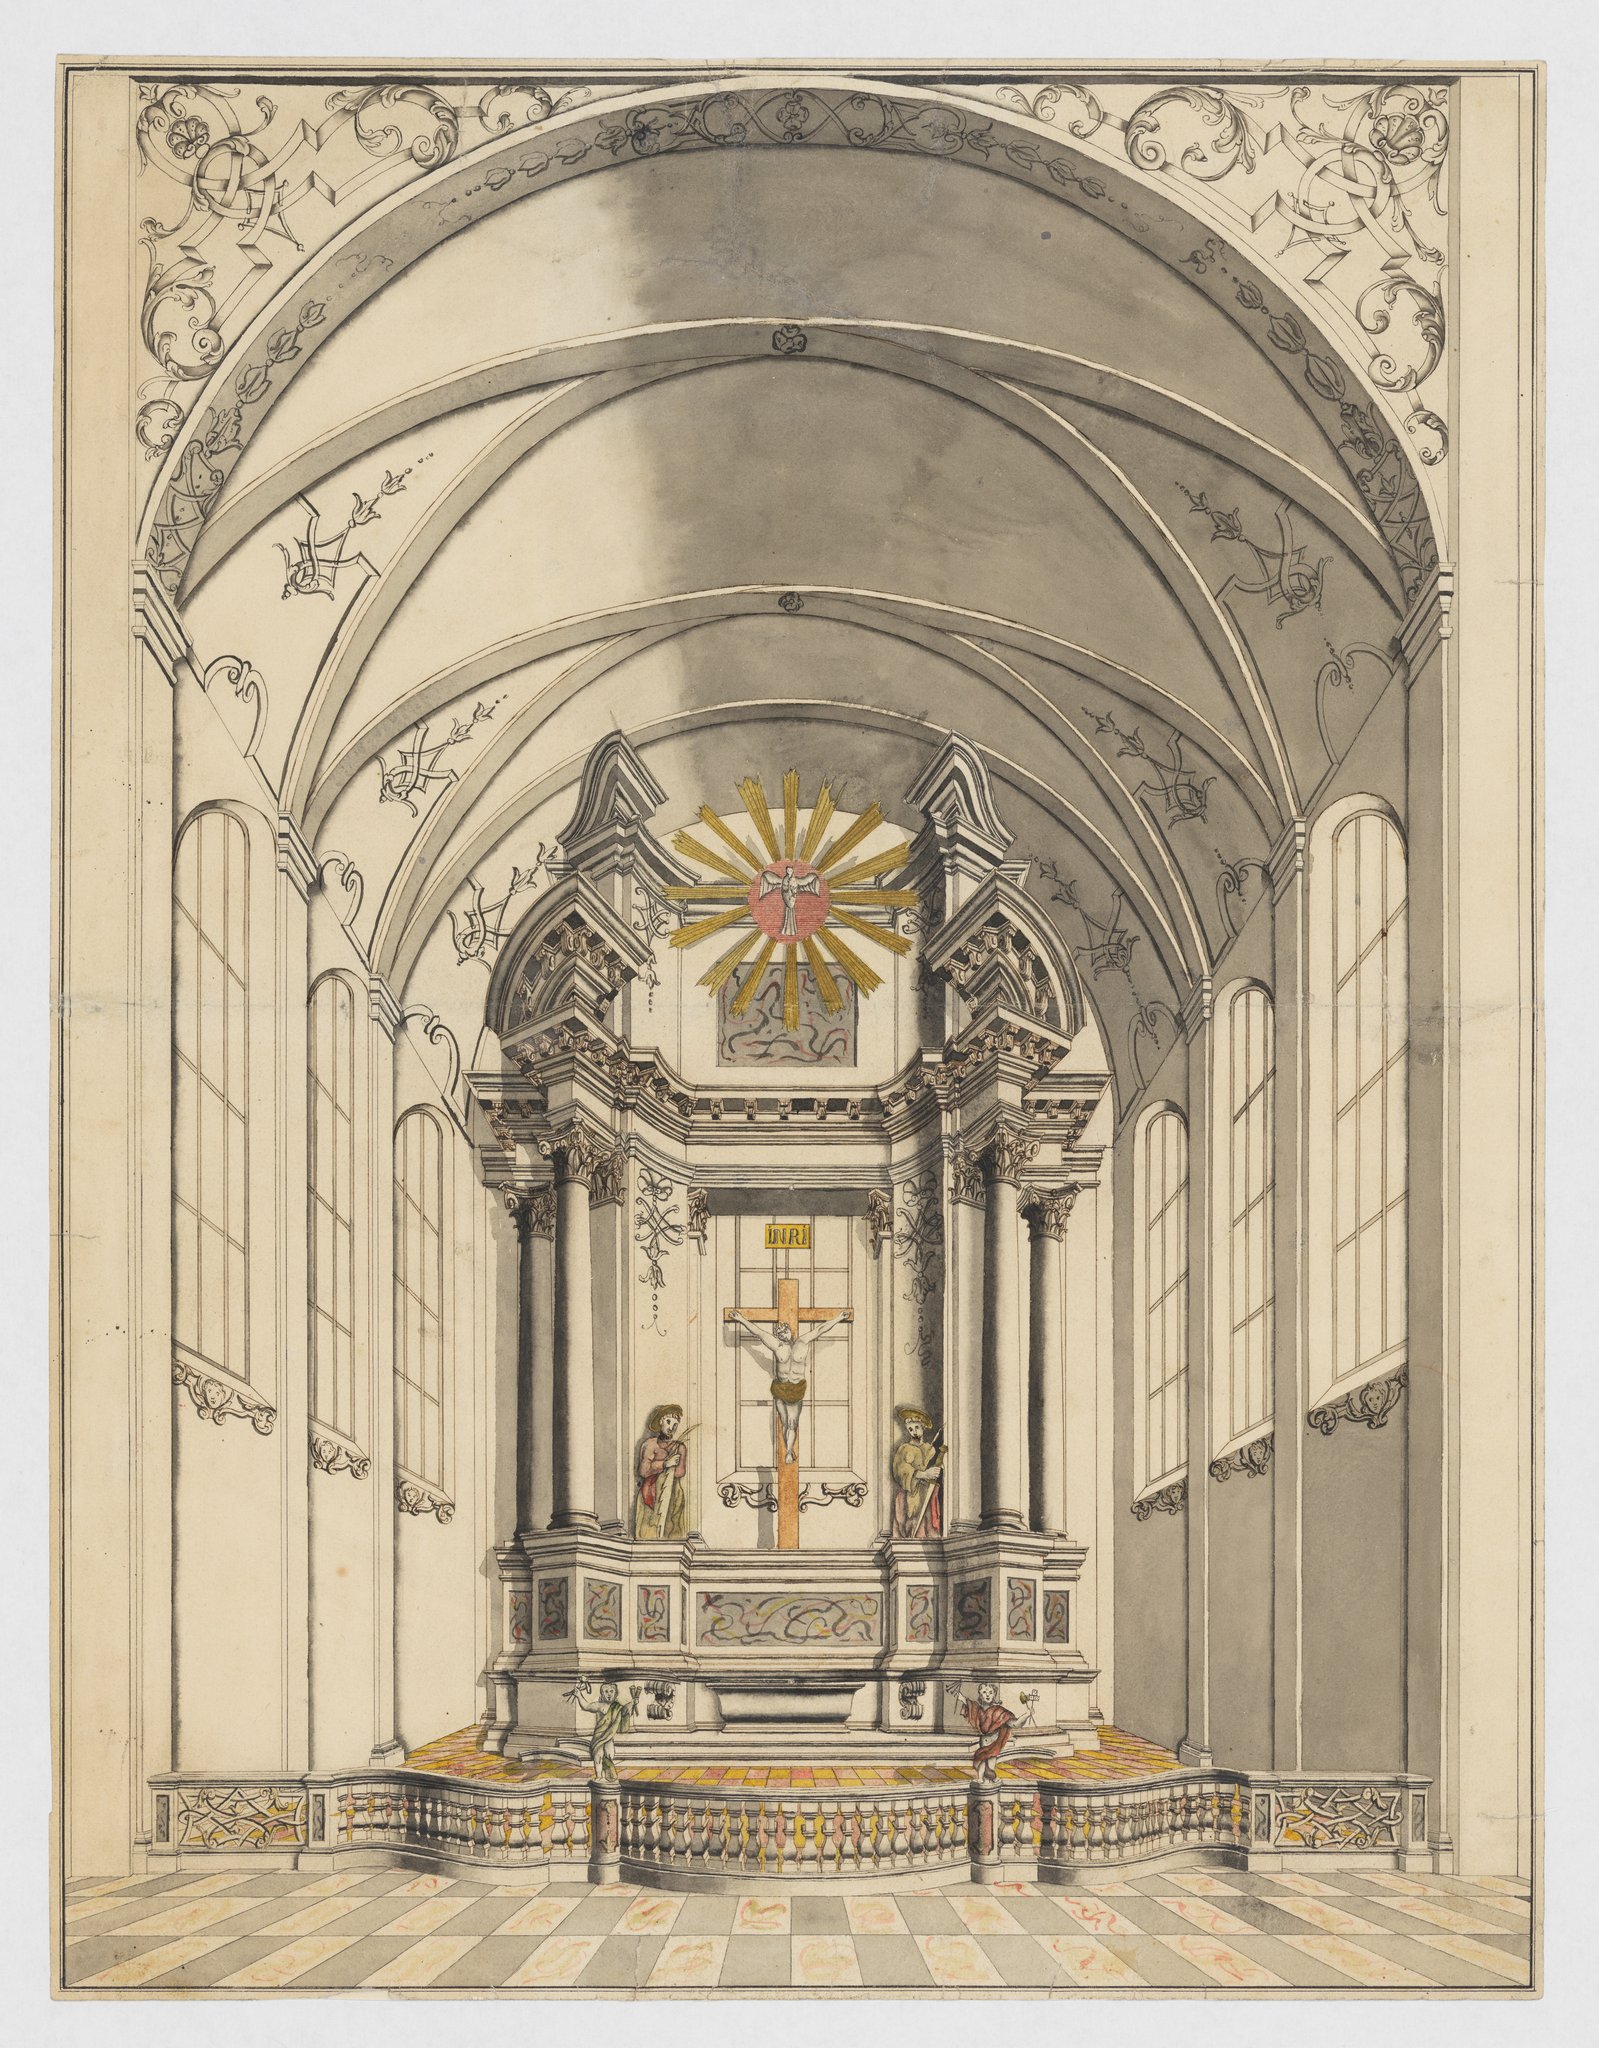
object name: ornament architecture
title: Presentation Drawing of a late Baroque Altar inside a Church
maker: anonymous, central european, 18th century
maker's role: artist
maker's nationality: central european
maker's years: 1700-1800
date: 1720-1730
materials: ink, pigment, watercolor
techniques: brush, pen, wash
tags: altars